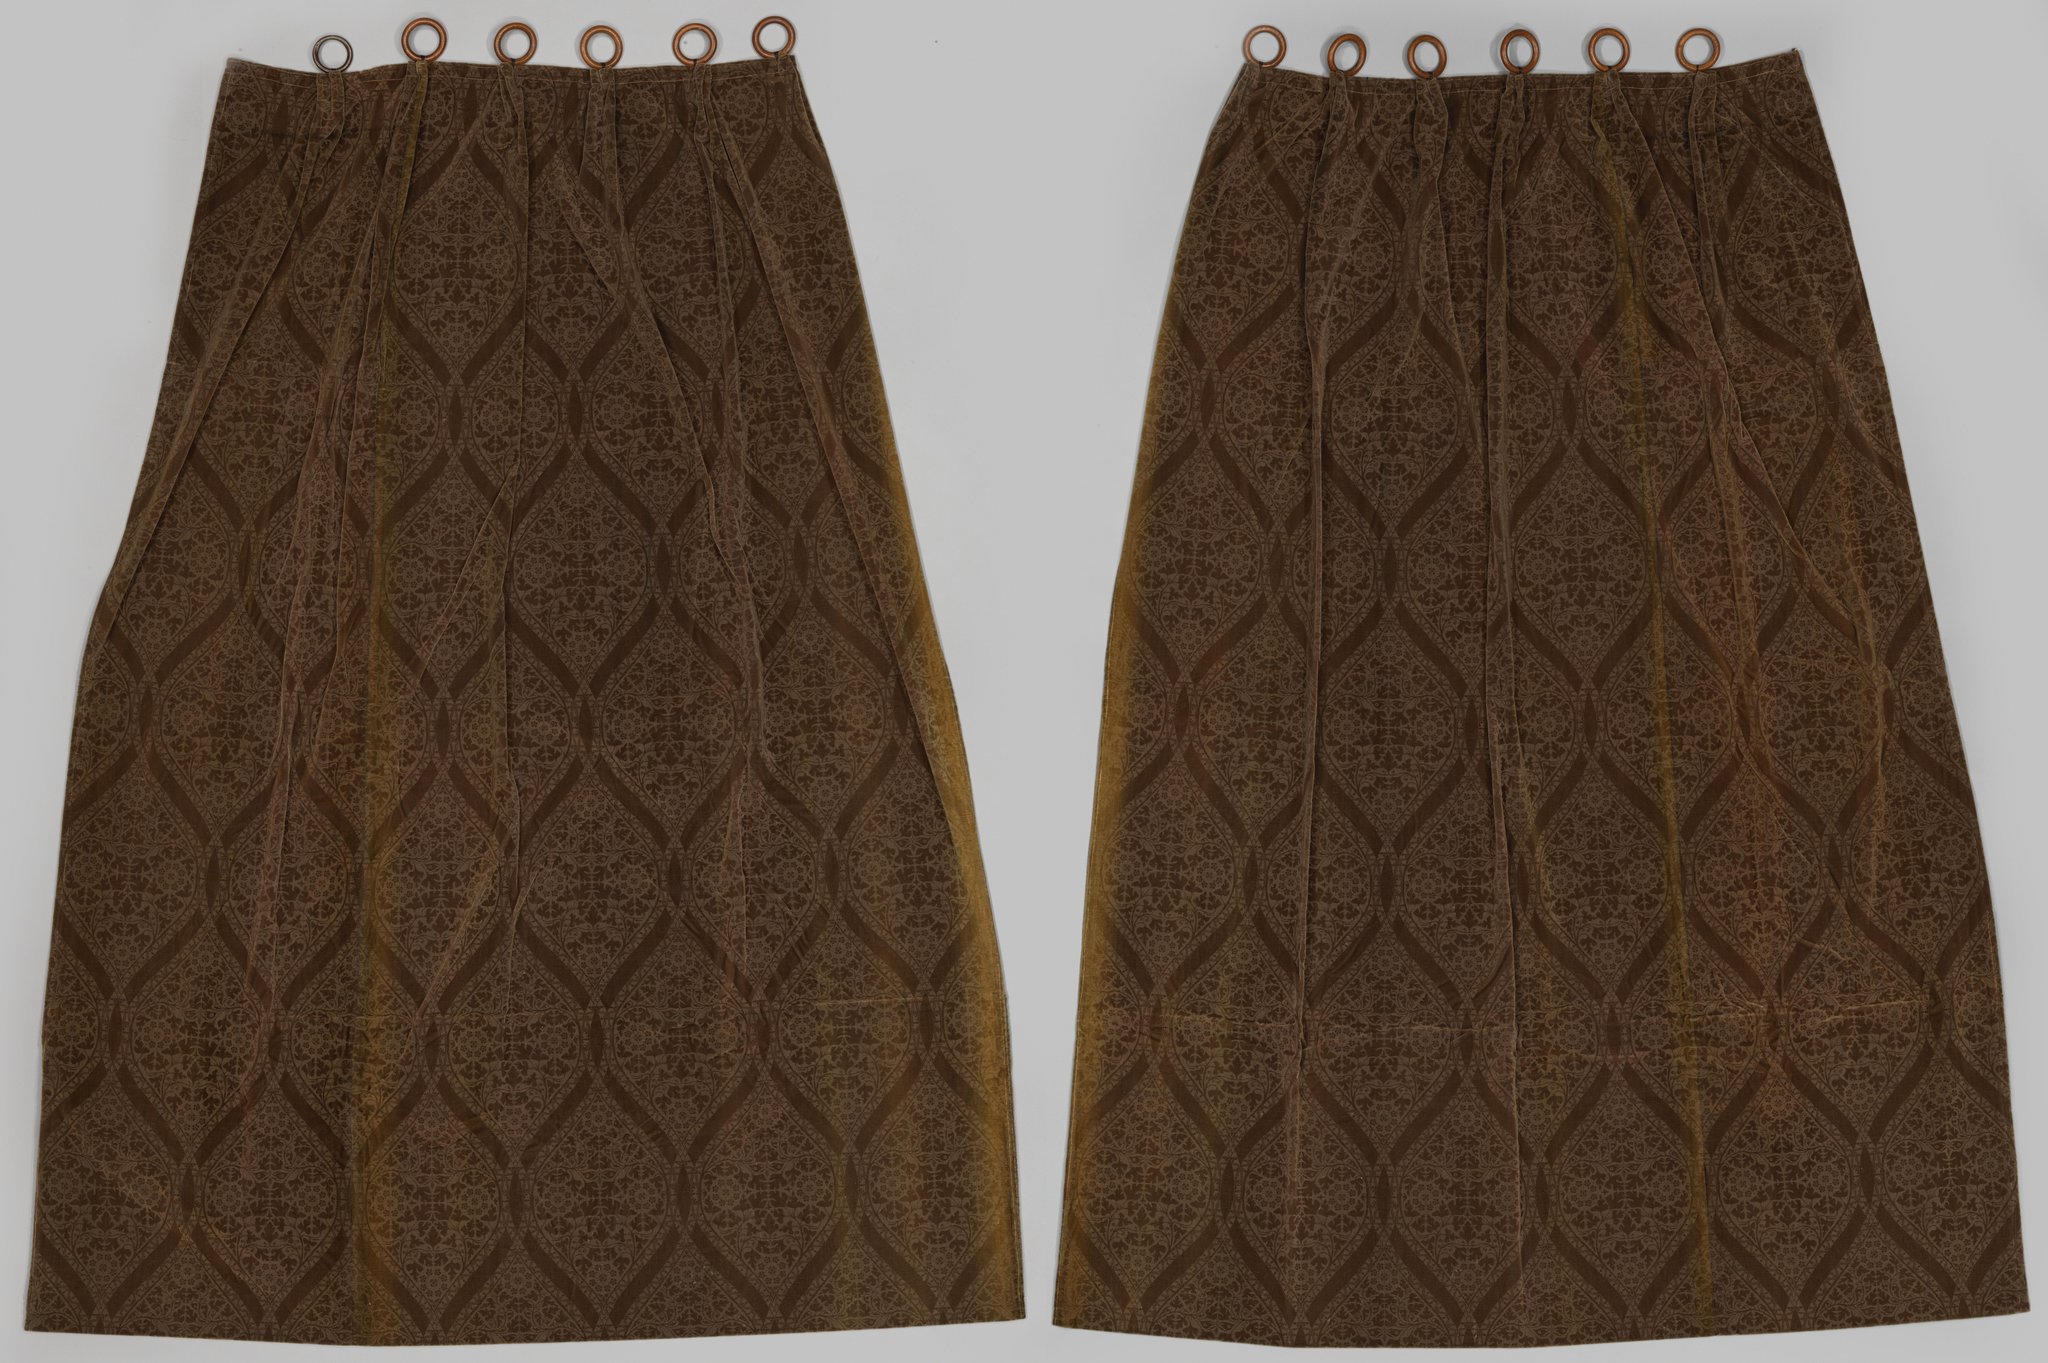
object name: curtain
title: Gordijnen van bruine trijp met dessin "Meiranken"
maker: theo nieuwenhuis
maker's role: designer, draughtsman, print maker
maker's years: 1866-1951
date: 1909-1920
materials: cotton, metal, textile, hair, wood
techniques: velvet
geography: netherlands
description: Gordijnen van bruine trijp (velours frisé) met dessin "Meiranken", bestaande uit een vlinder, bladranken en bloemenkranzen binnen spitsovalen. Voorzien van één metalen en elf houten ringen. Mogelijk gerelateerd aan V-69770 en V-69771.